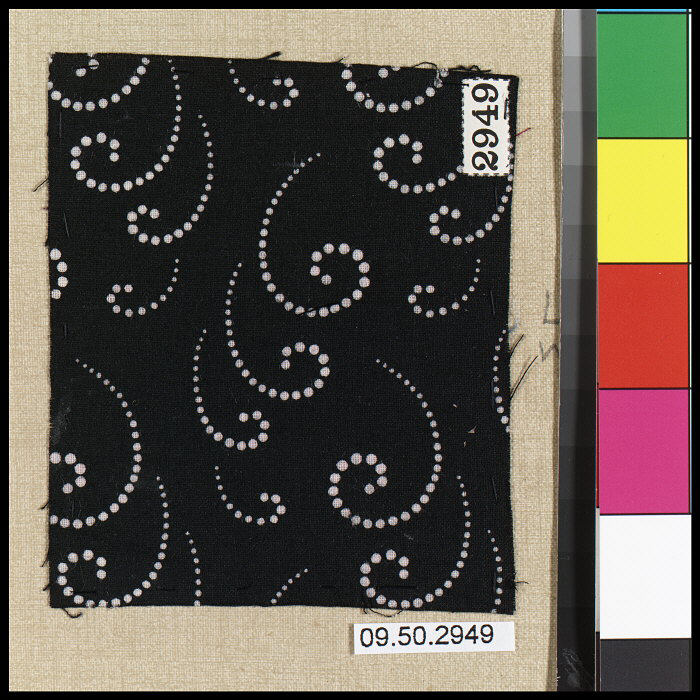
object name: piece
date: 1801-1900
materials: cotton